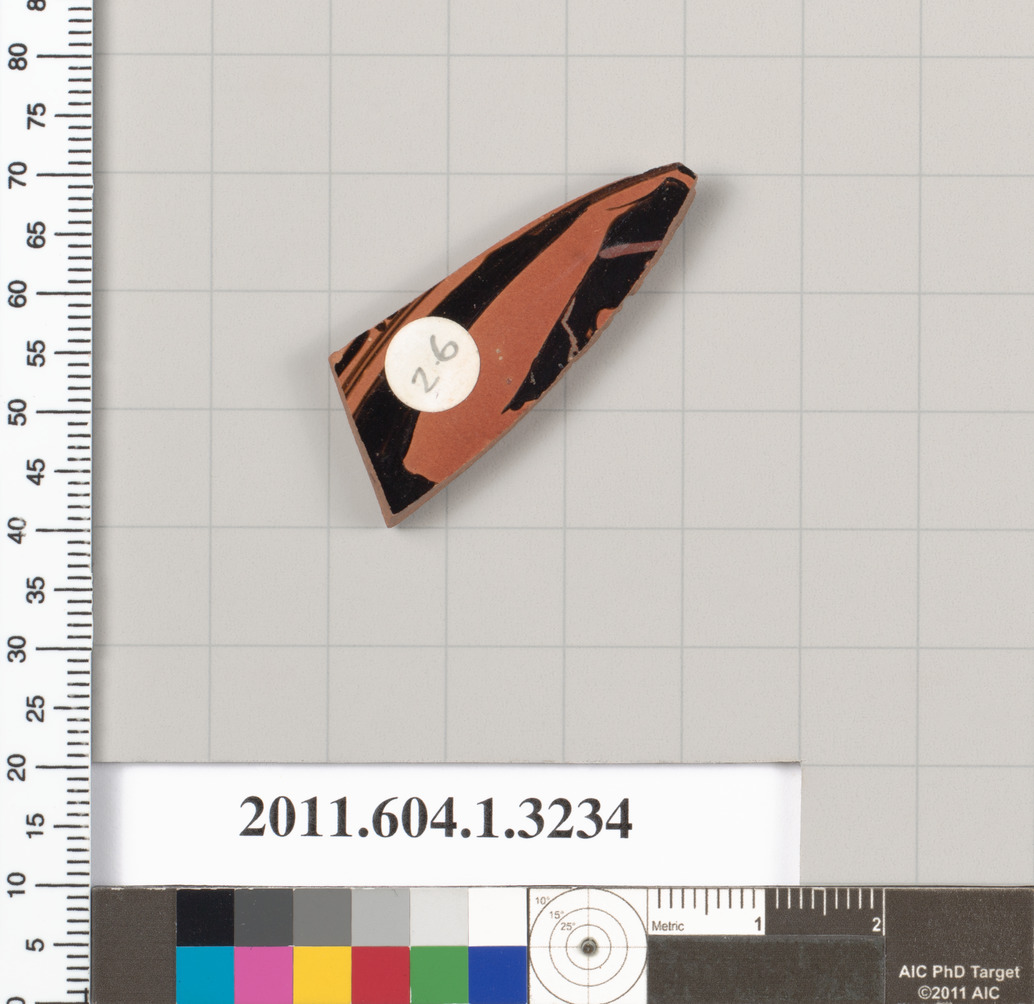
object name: kylix fragment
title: Terracotta fragment of a kylix (drinking cup)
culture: greek, attic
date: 500-476 BCE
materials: terracotta